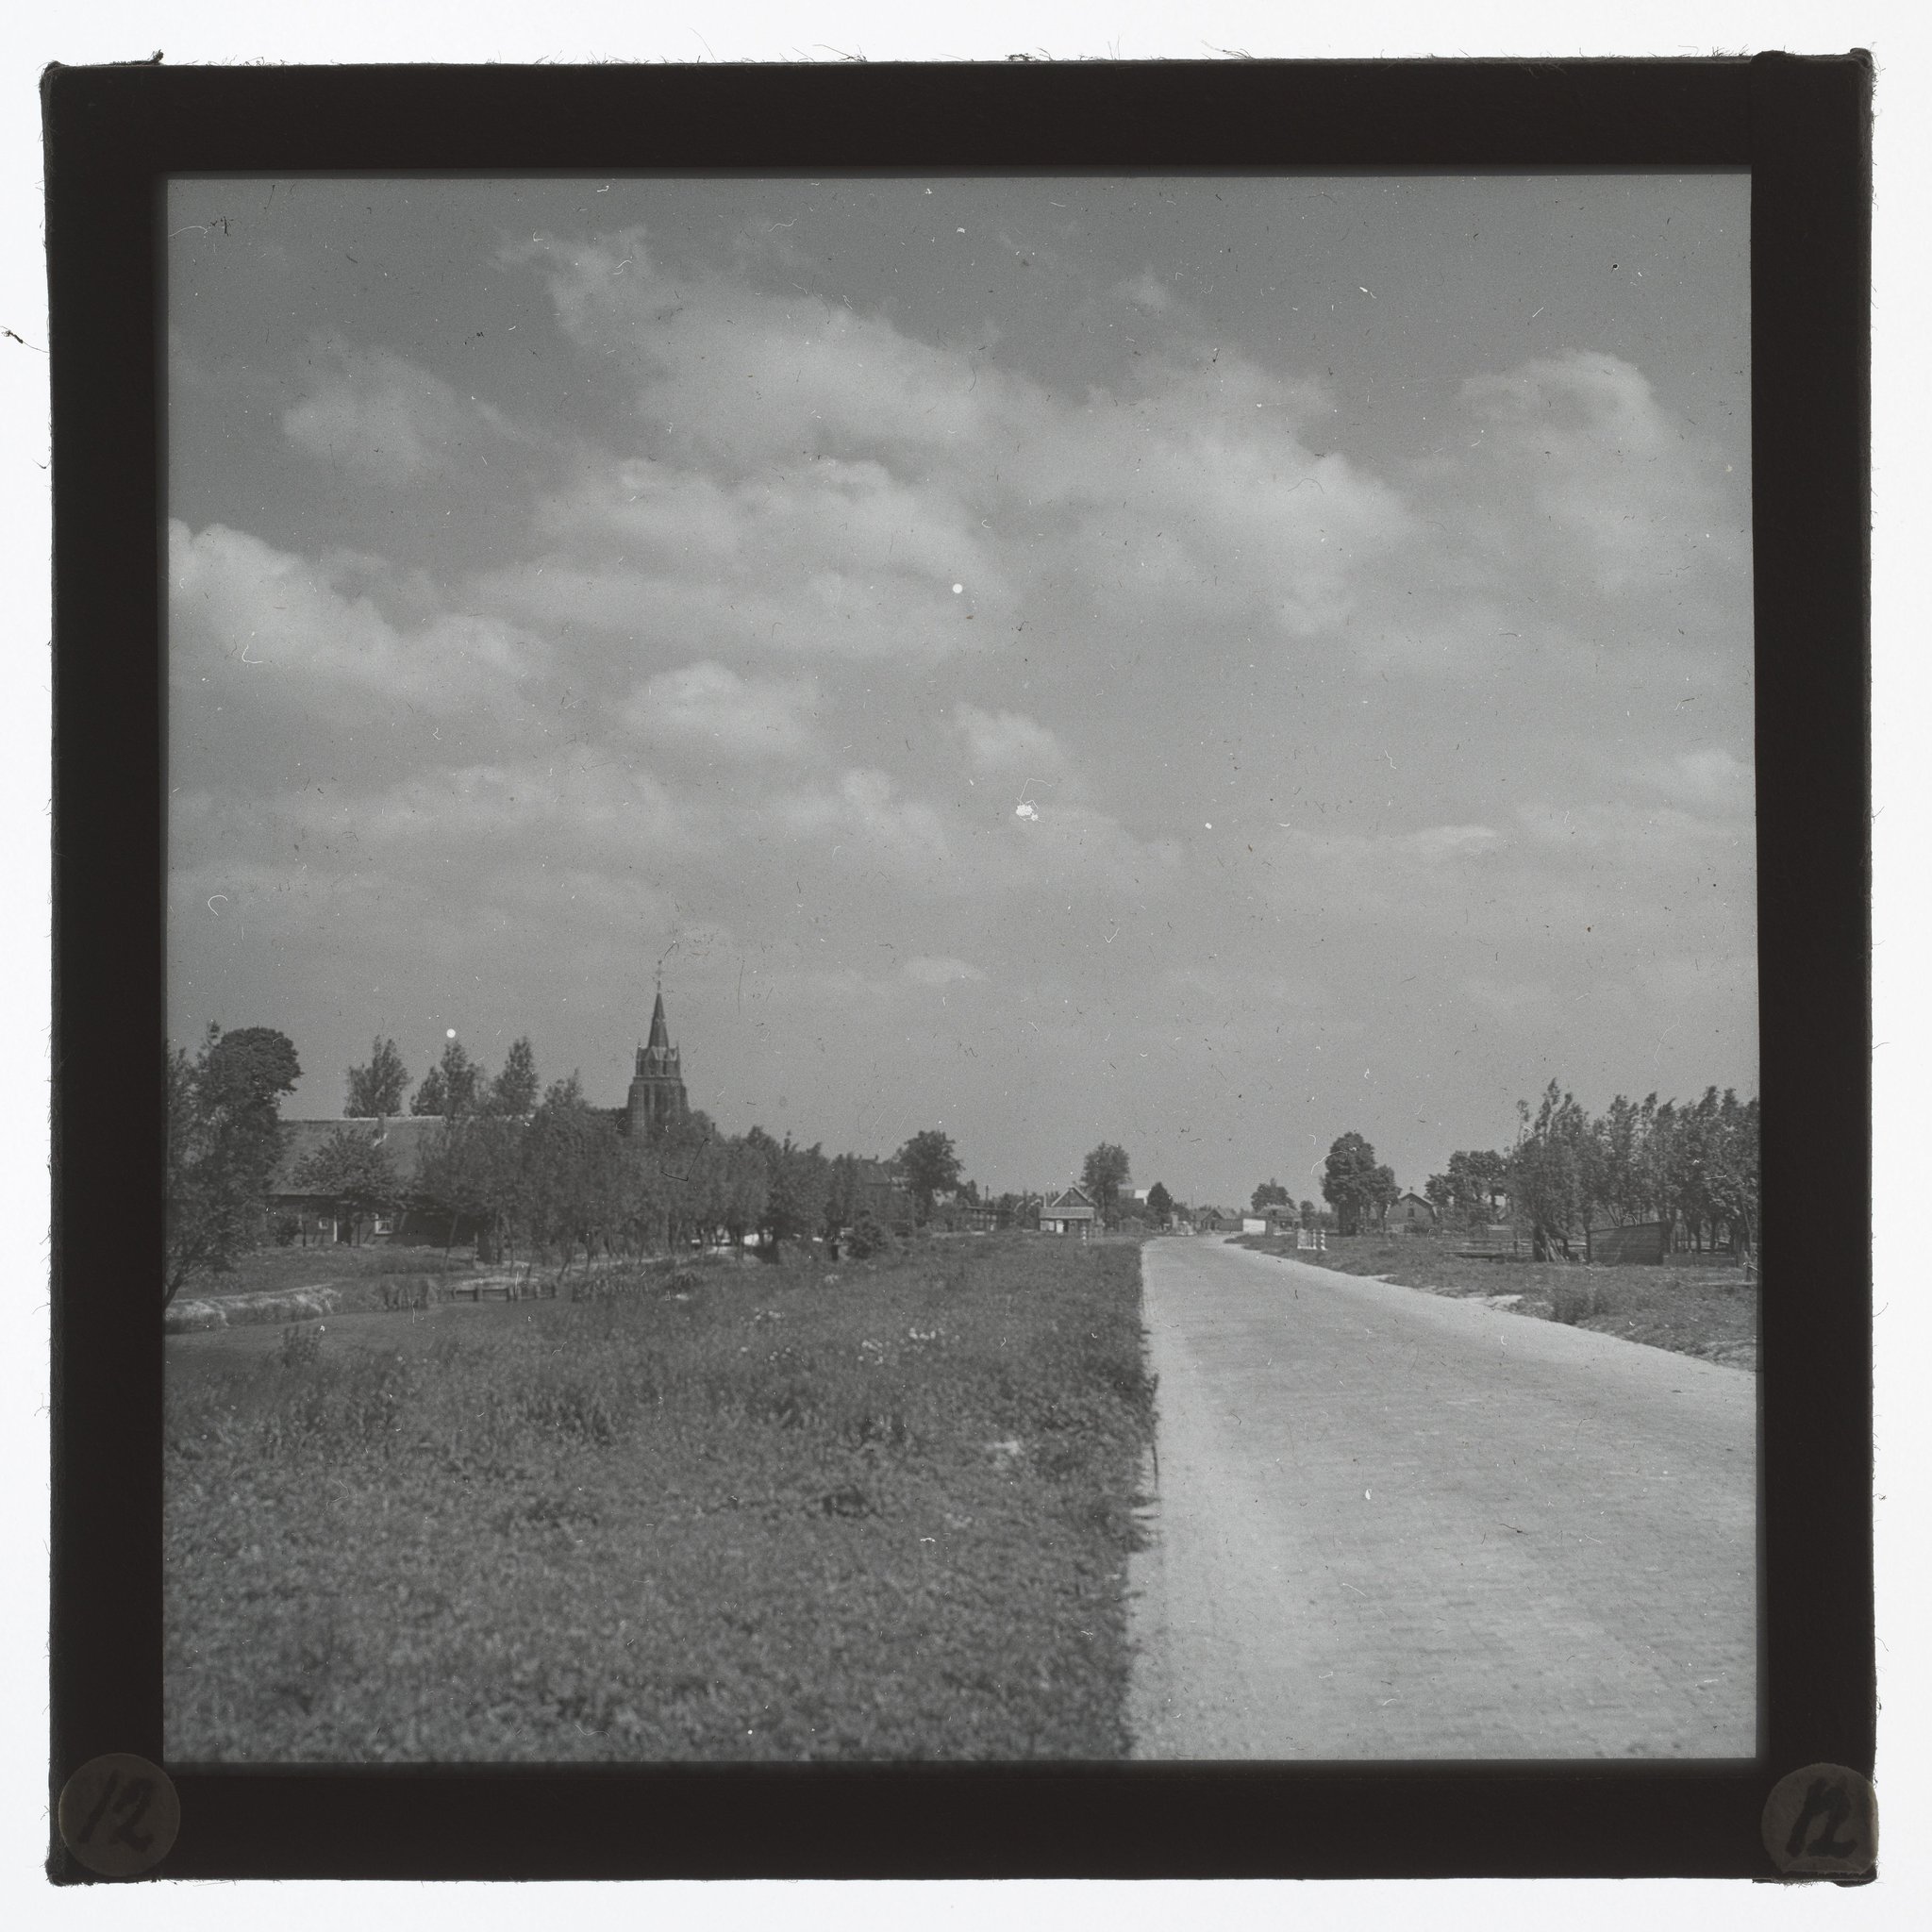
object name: lantern slide photographic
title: Gezicht op een voltooide weg, Zuid-Holland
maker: Anonymous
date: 1956-1960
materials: glass, paper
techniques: gelatin silver transparency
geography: south holland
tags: public road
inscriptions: number: ‘12’